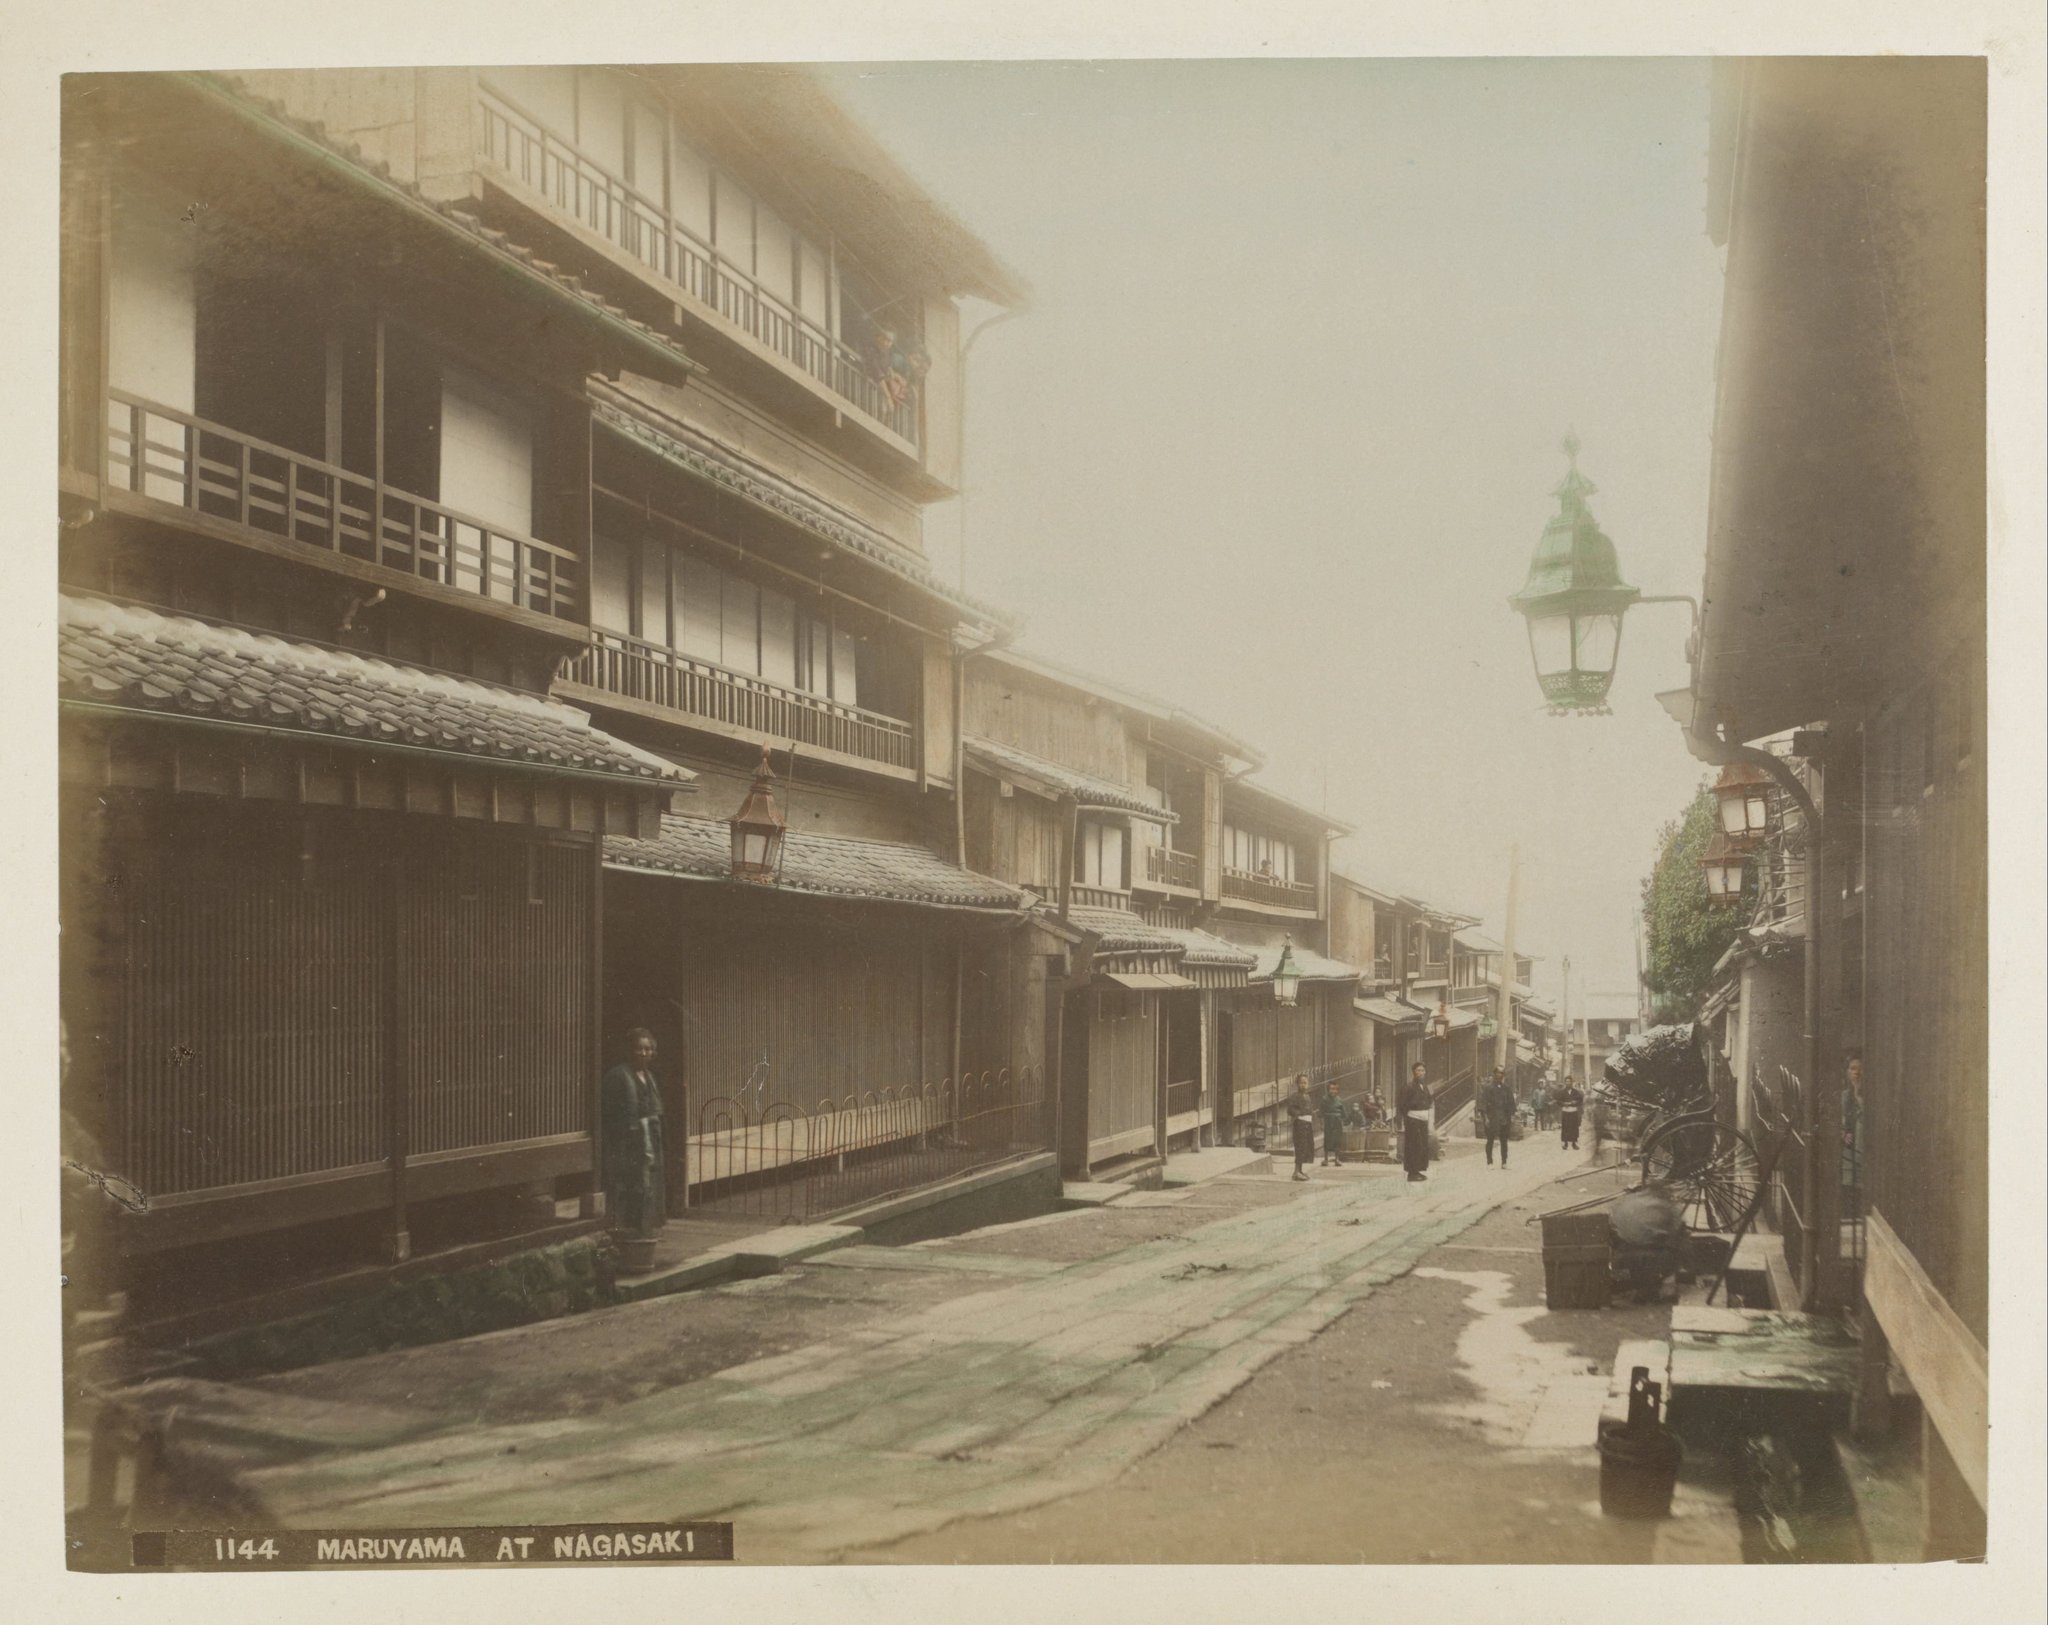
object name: photograph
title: Maruyama at Nagasaki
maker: Anonymous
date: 1870-1900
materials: paper, photographic support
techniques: albumen print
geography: nagasaki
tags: rickshaw, travelling; tourism, street (+ city(-scape) with figures, staffage)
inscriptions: negative number: ‘1144’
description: Onderdeel van Fotoalbum met 50 foto's van bezienswaardigheden in Japan.